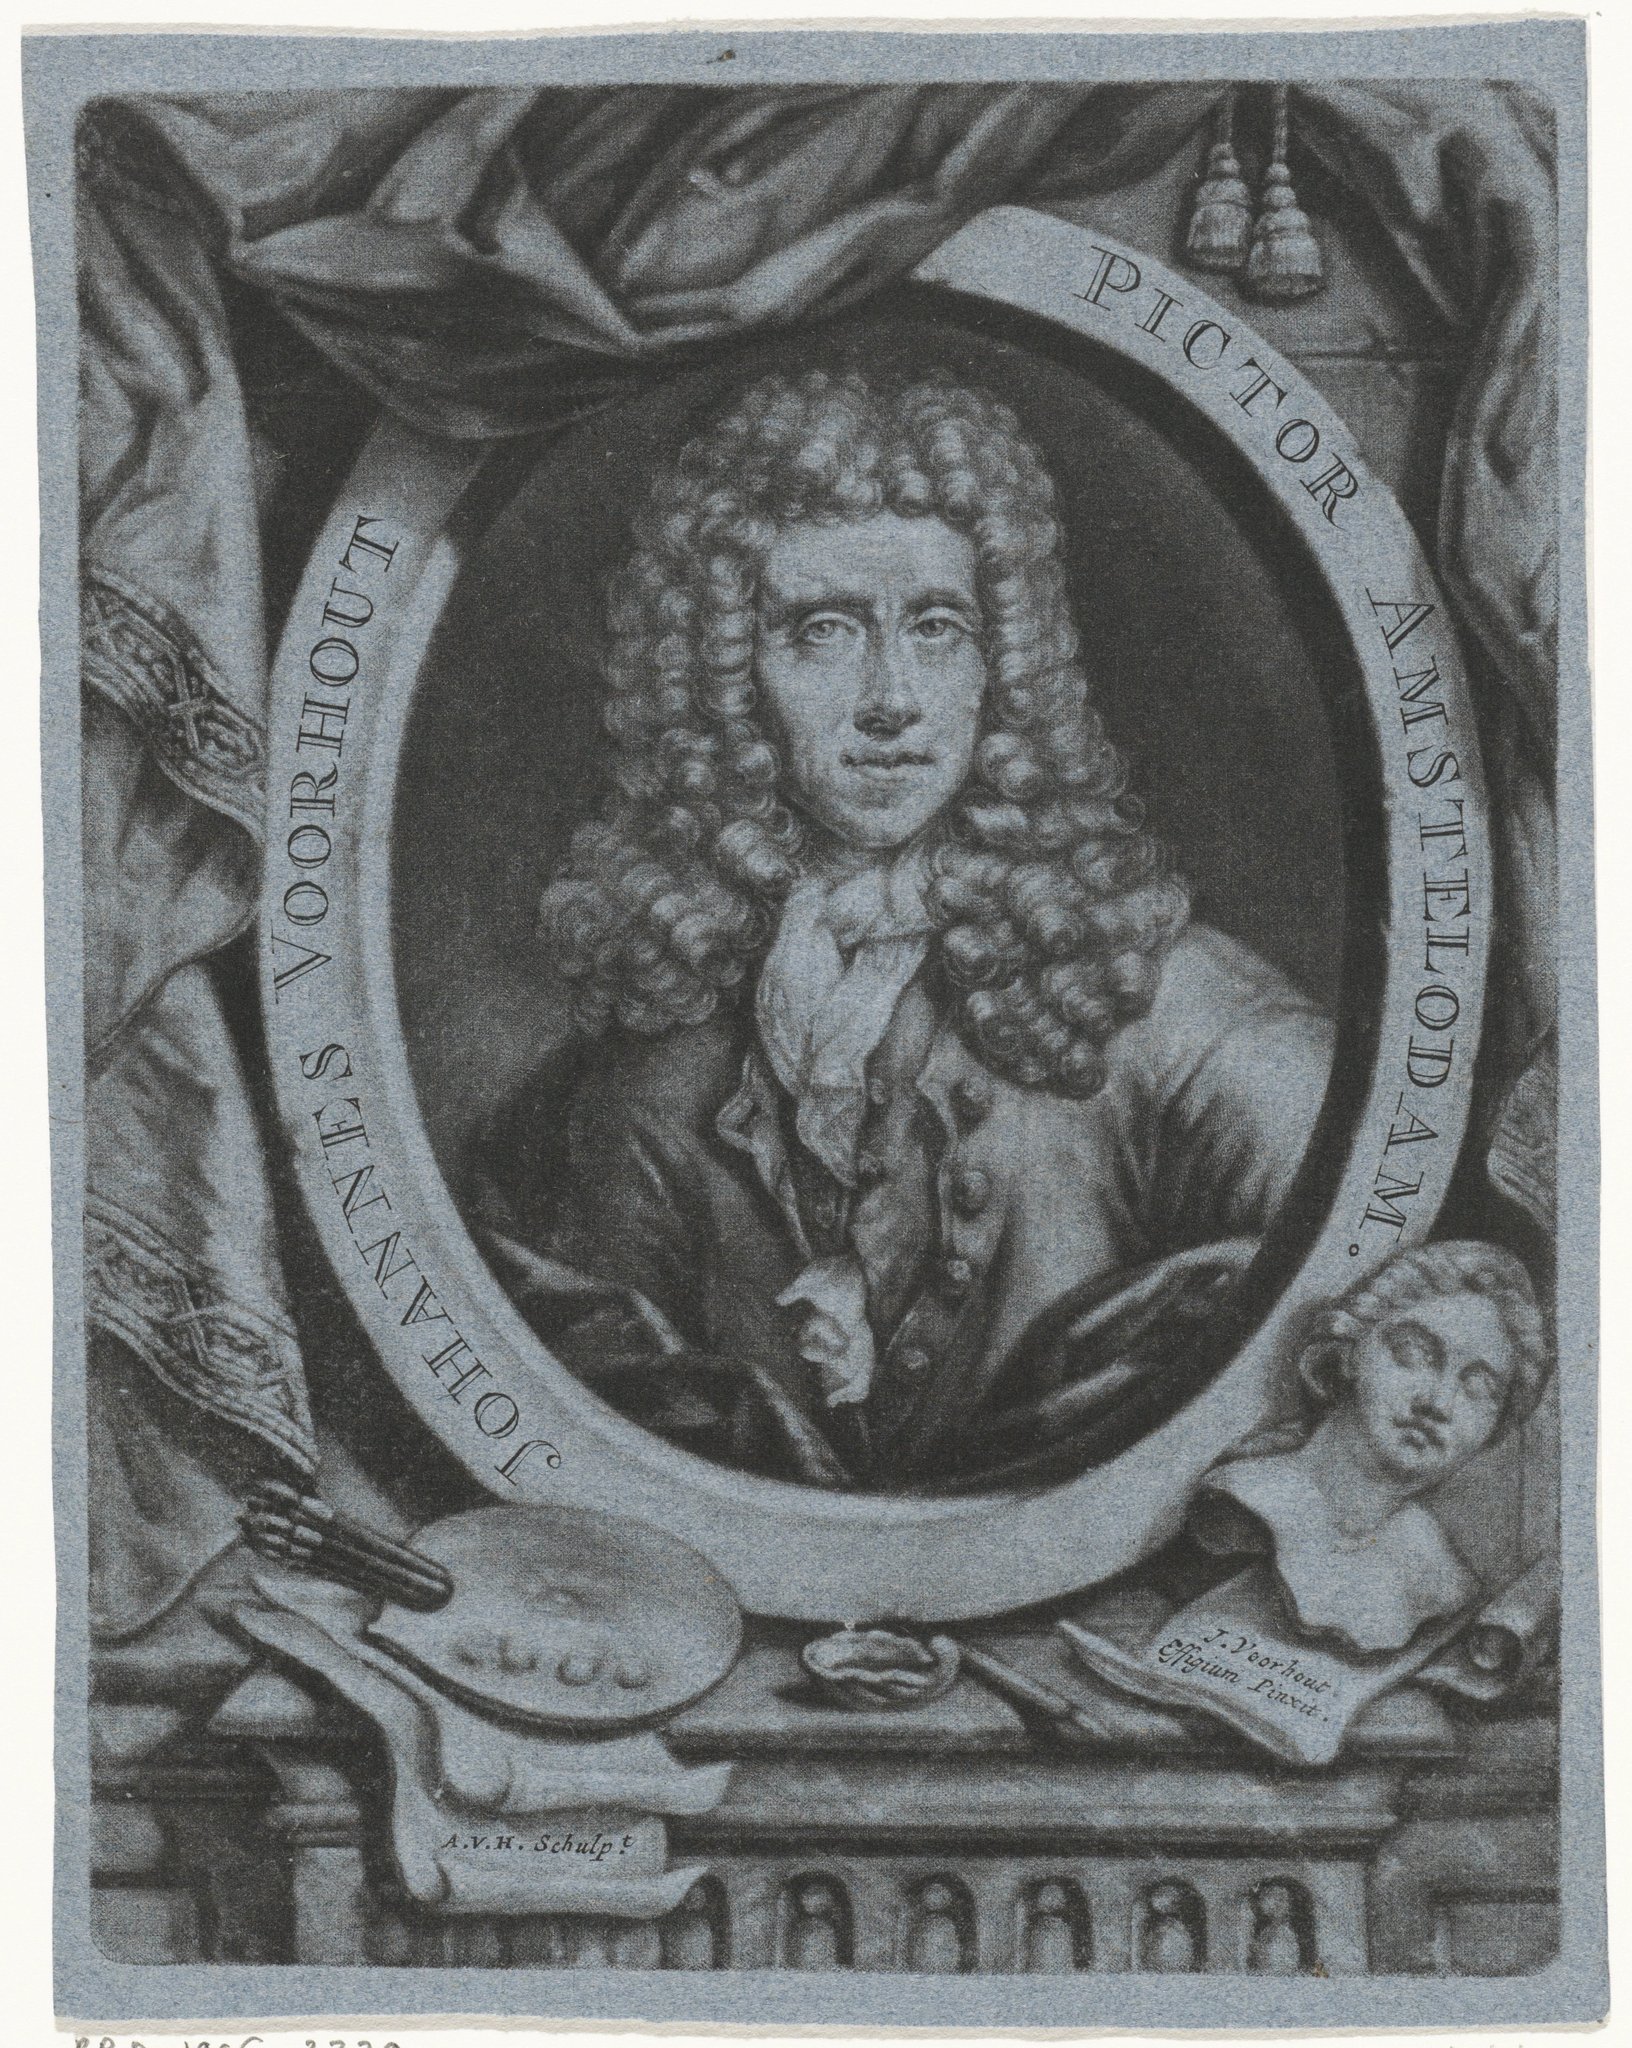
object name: print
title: Portret van Johannes Voorhout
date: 1683-1732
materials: paper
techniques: engraving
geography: amsterdam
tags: amsterdam, draughtsman, johannes voorhout (i), tools, implements of painter, portrait, self-portrait of artist, wig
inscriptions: collector's mark: Lugt 2228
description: De tekenaar en schilder Johannes Voorhout gevat in een met schildersattributen gedecoreerde omlijsting. Hij draagt een lange pruik.